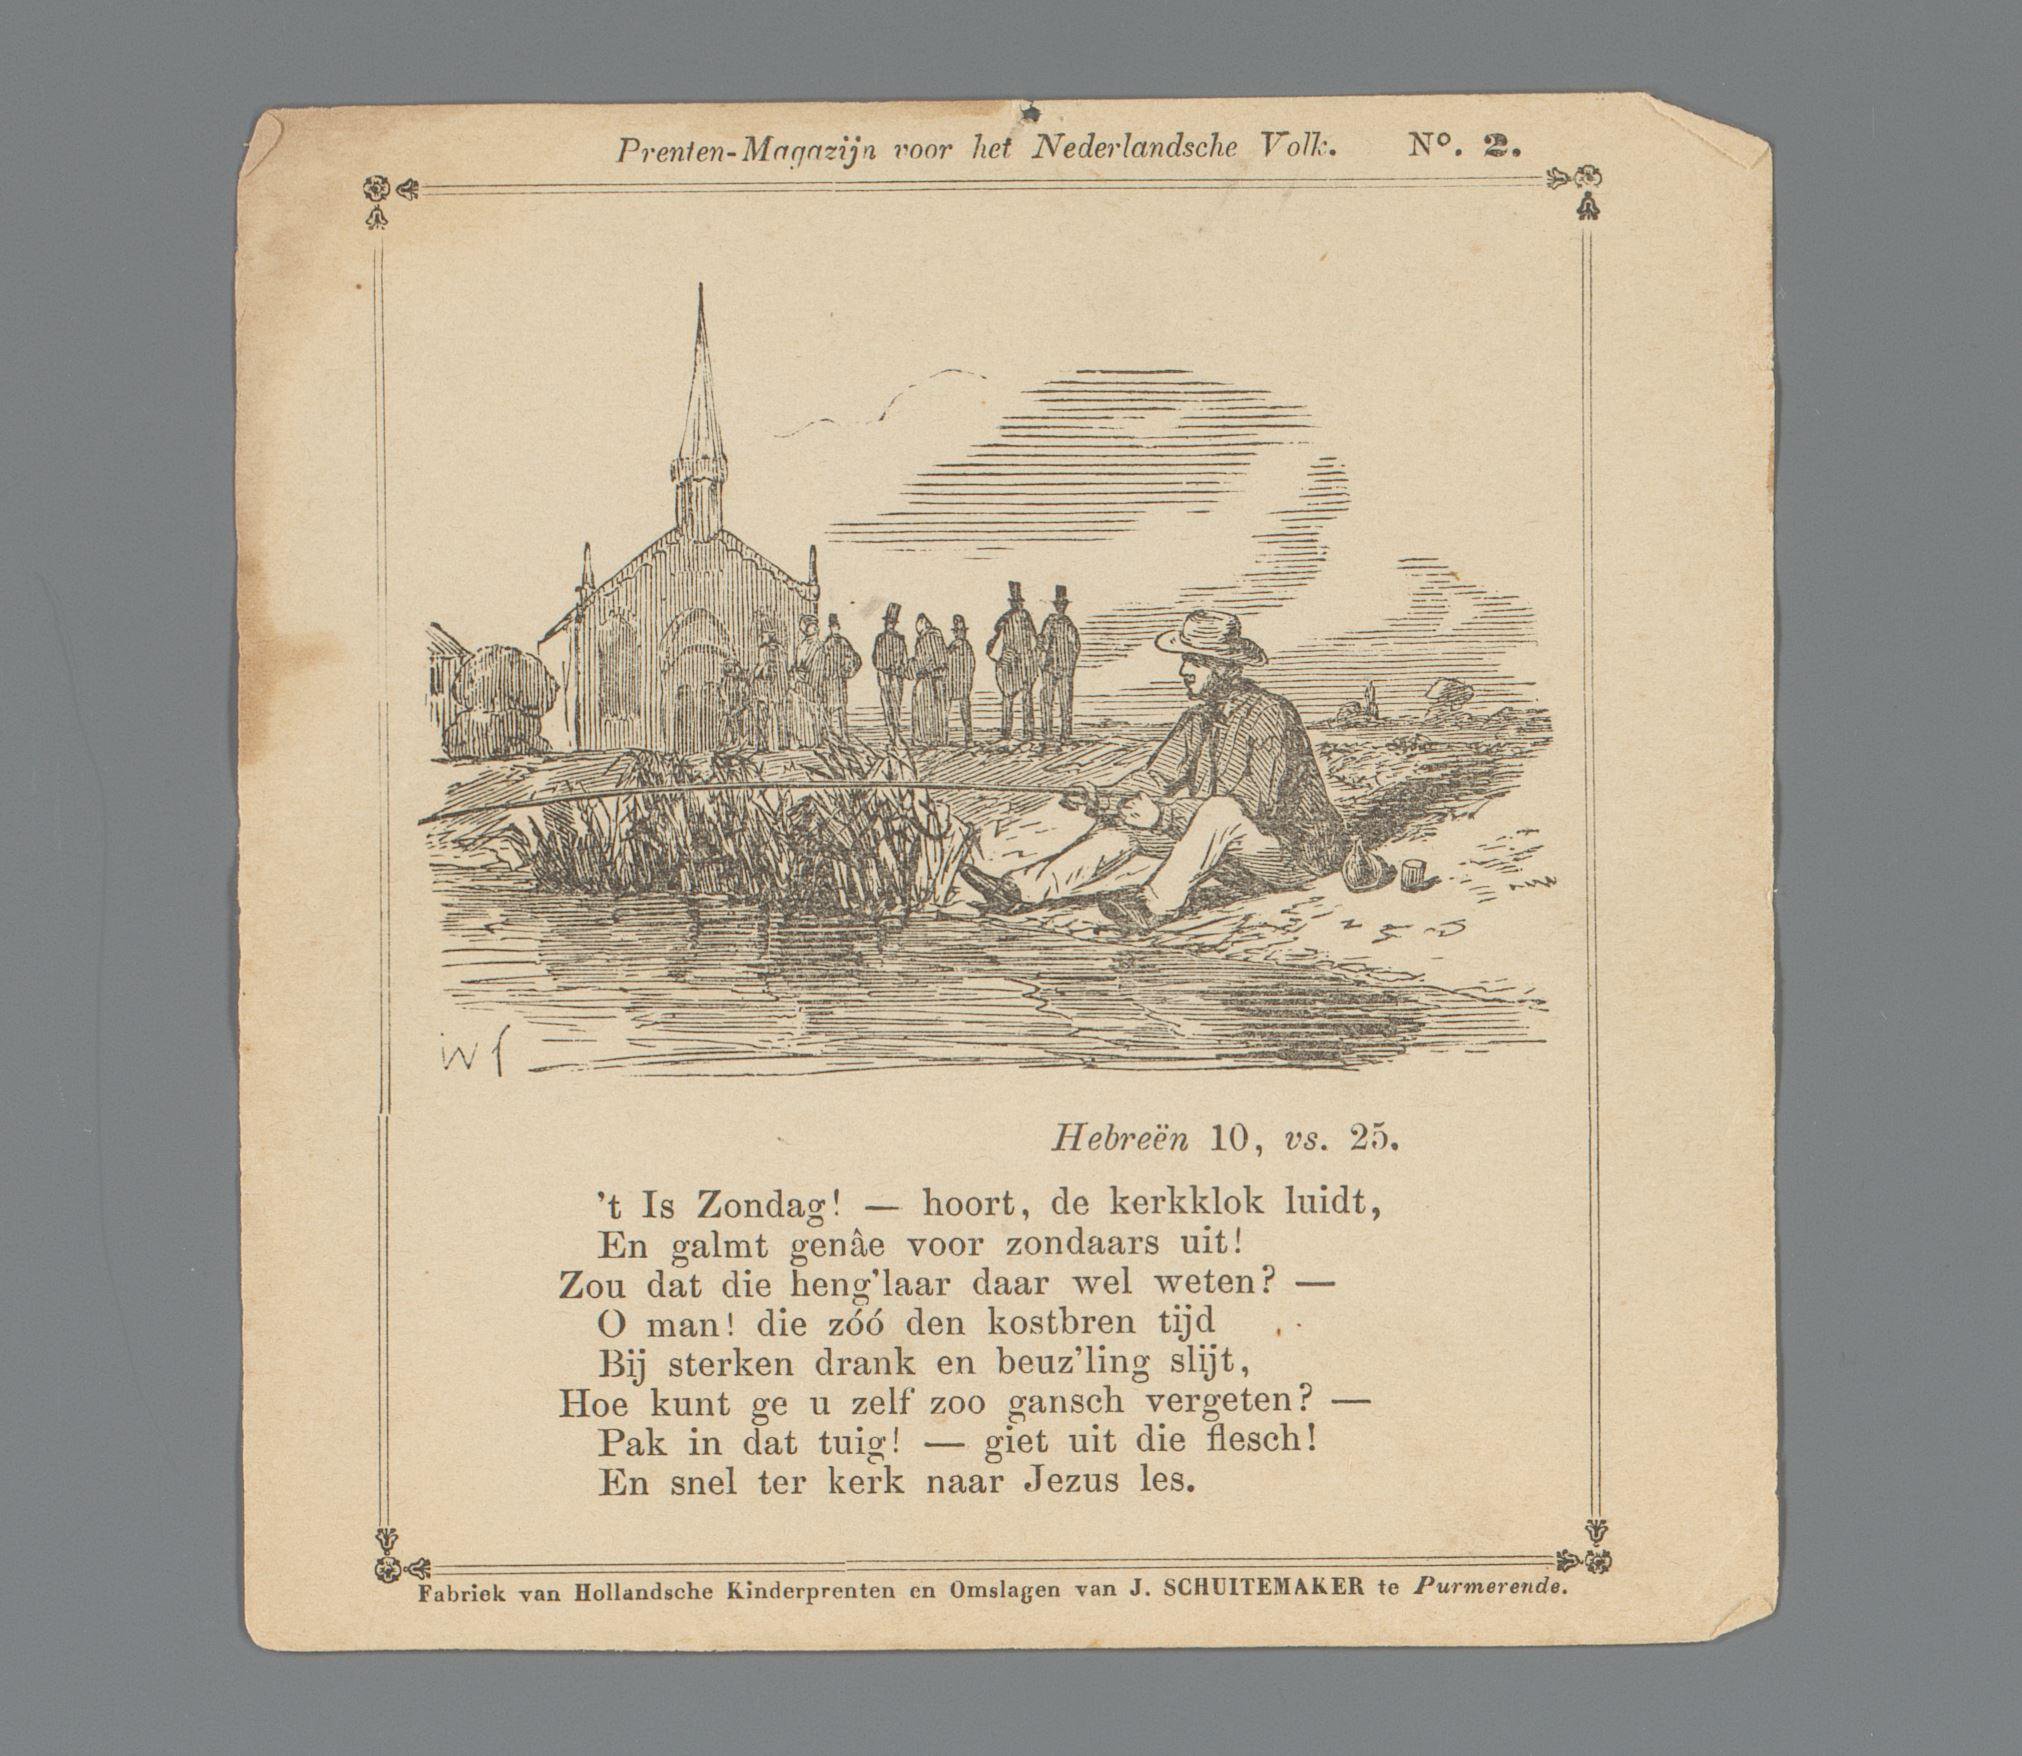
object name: print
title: Vissende man bij een kerk op zondag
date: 1838-1912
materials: paper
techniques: letterpress printing, engraving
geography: netherlands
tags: genever, gin, alcoholism, angling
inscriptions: collector's mark: Lugt 2228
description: Prent uit een serie van twaalf over het afschaffen van sterke drank. Onder de afbeelding een kort gedicht. Boven de afbeelding de regel: 'Prenten-Magazijn voor het Nederlandsche Volk'.